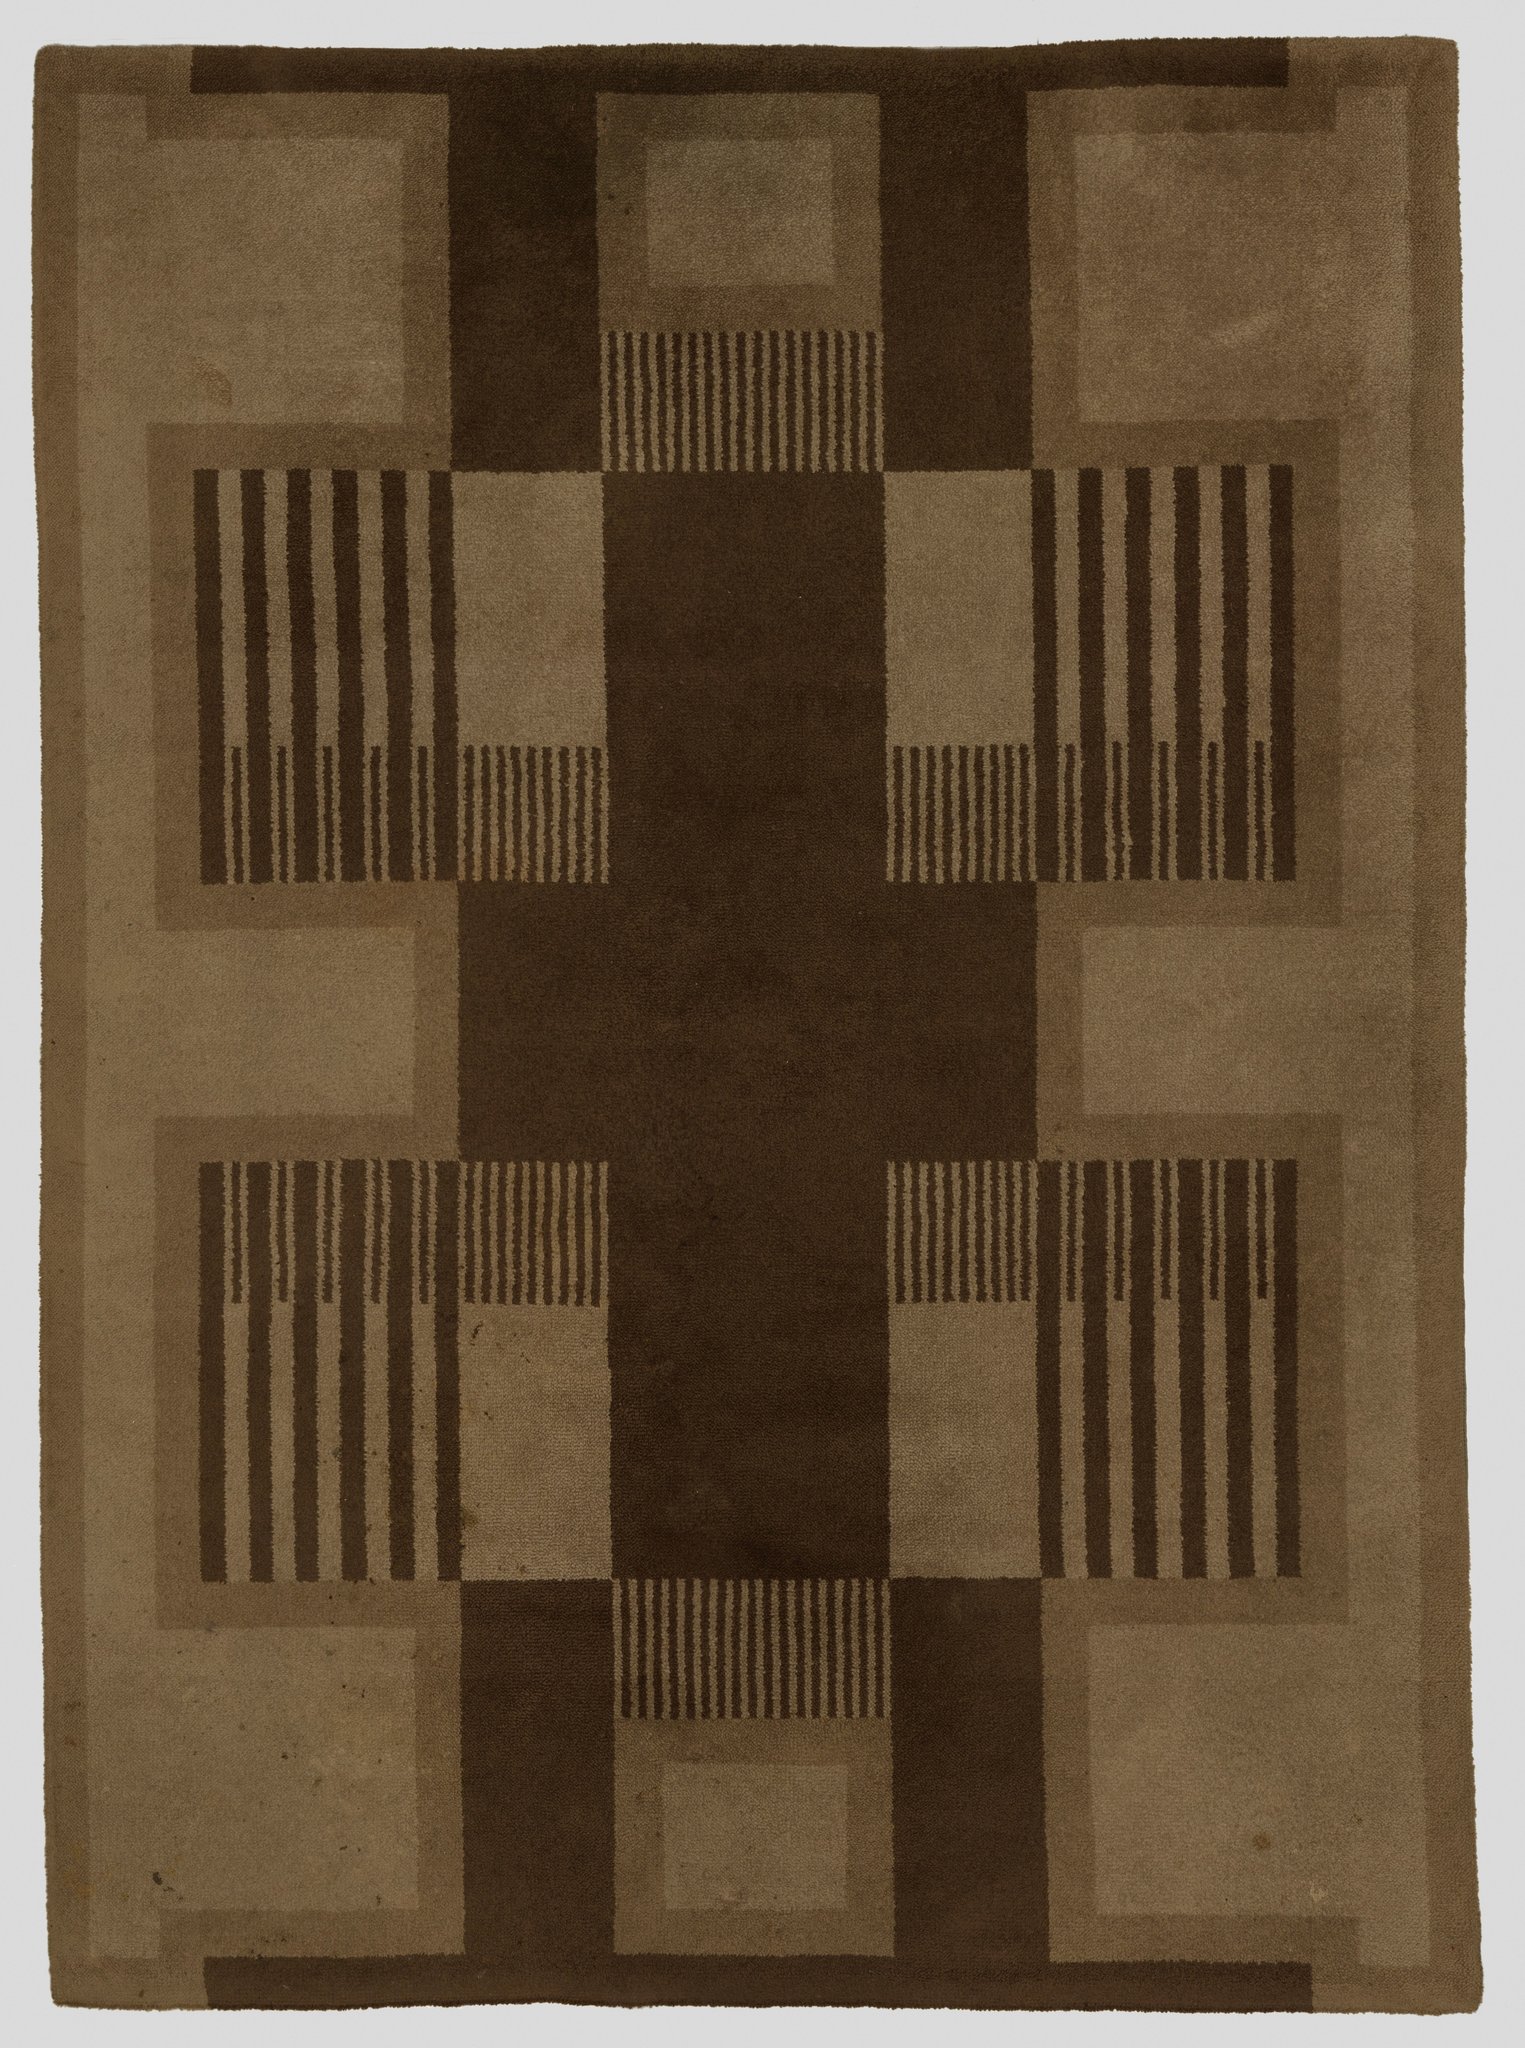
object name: kleed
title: Vloerkleed van wol in bruin en twee tinten beige, met een patroon van geometrische strepen en een kruis in het midden.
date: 1925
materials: wool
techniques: knotting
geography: moordrecht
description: Vloerkleed van wol in bruin en twee tinten beige, met een patroon van geometrische strepen en een kruis in het midden. Gemerkt: K.V.T. 25864.